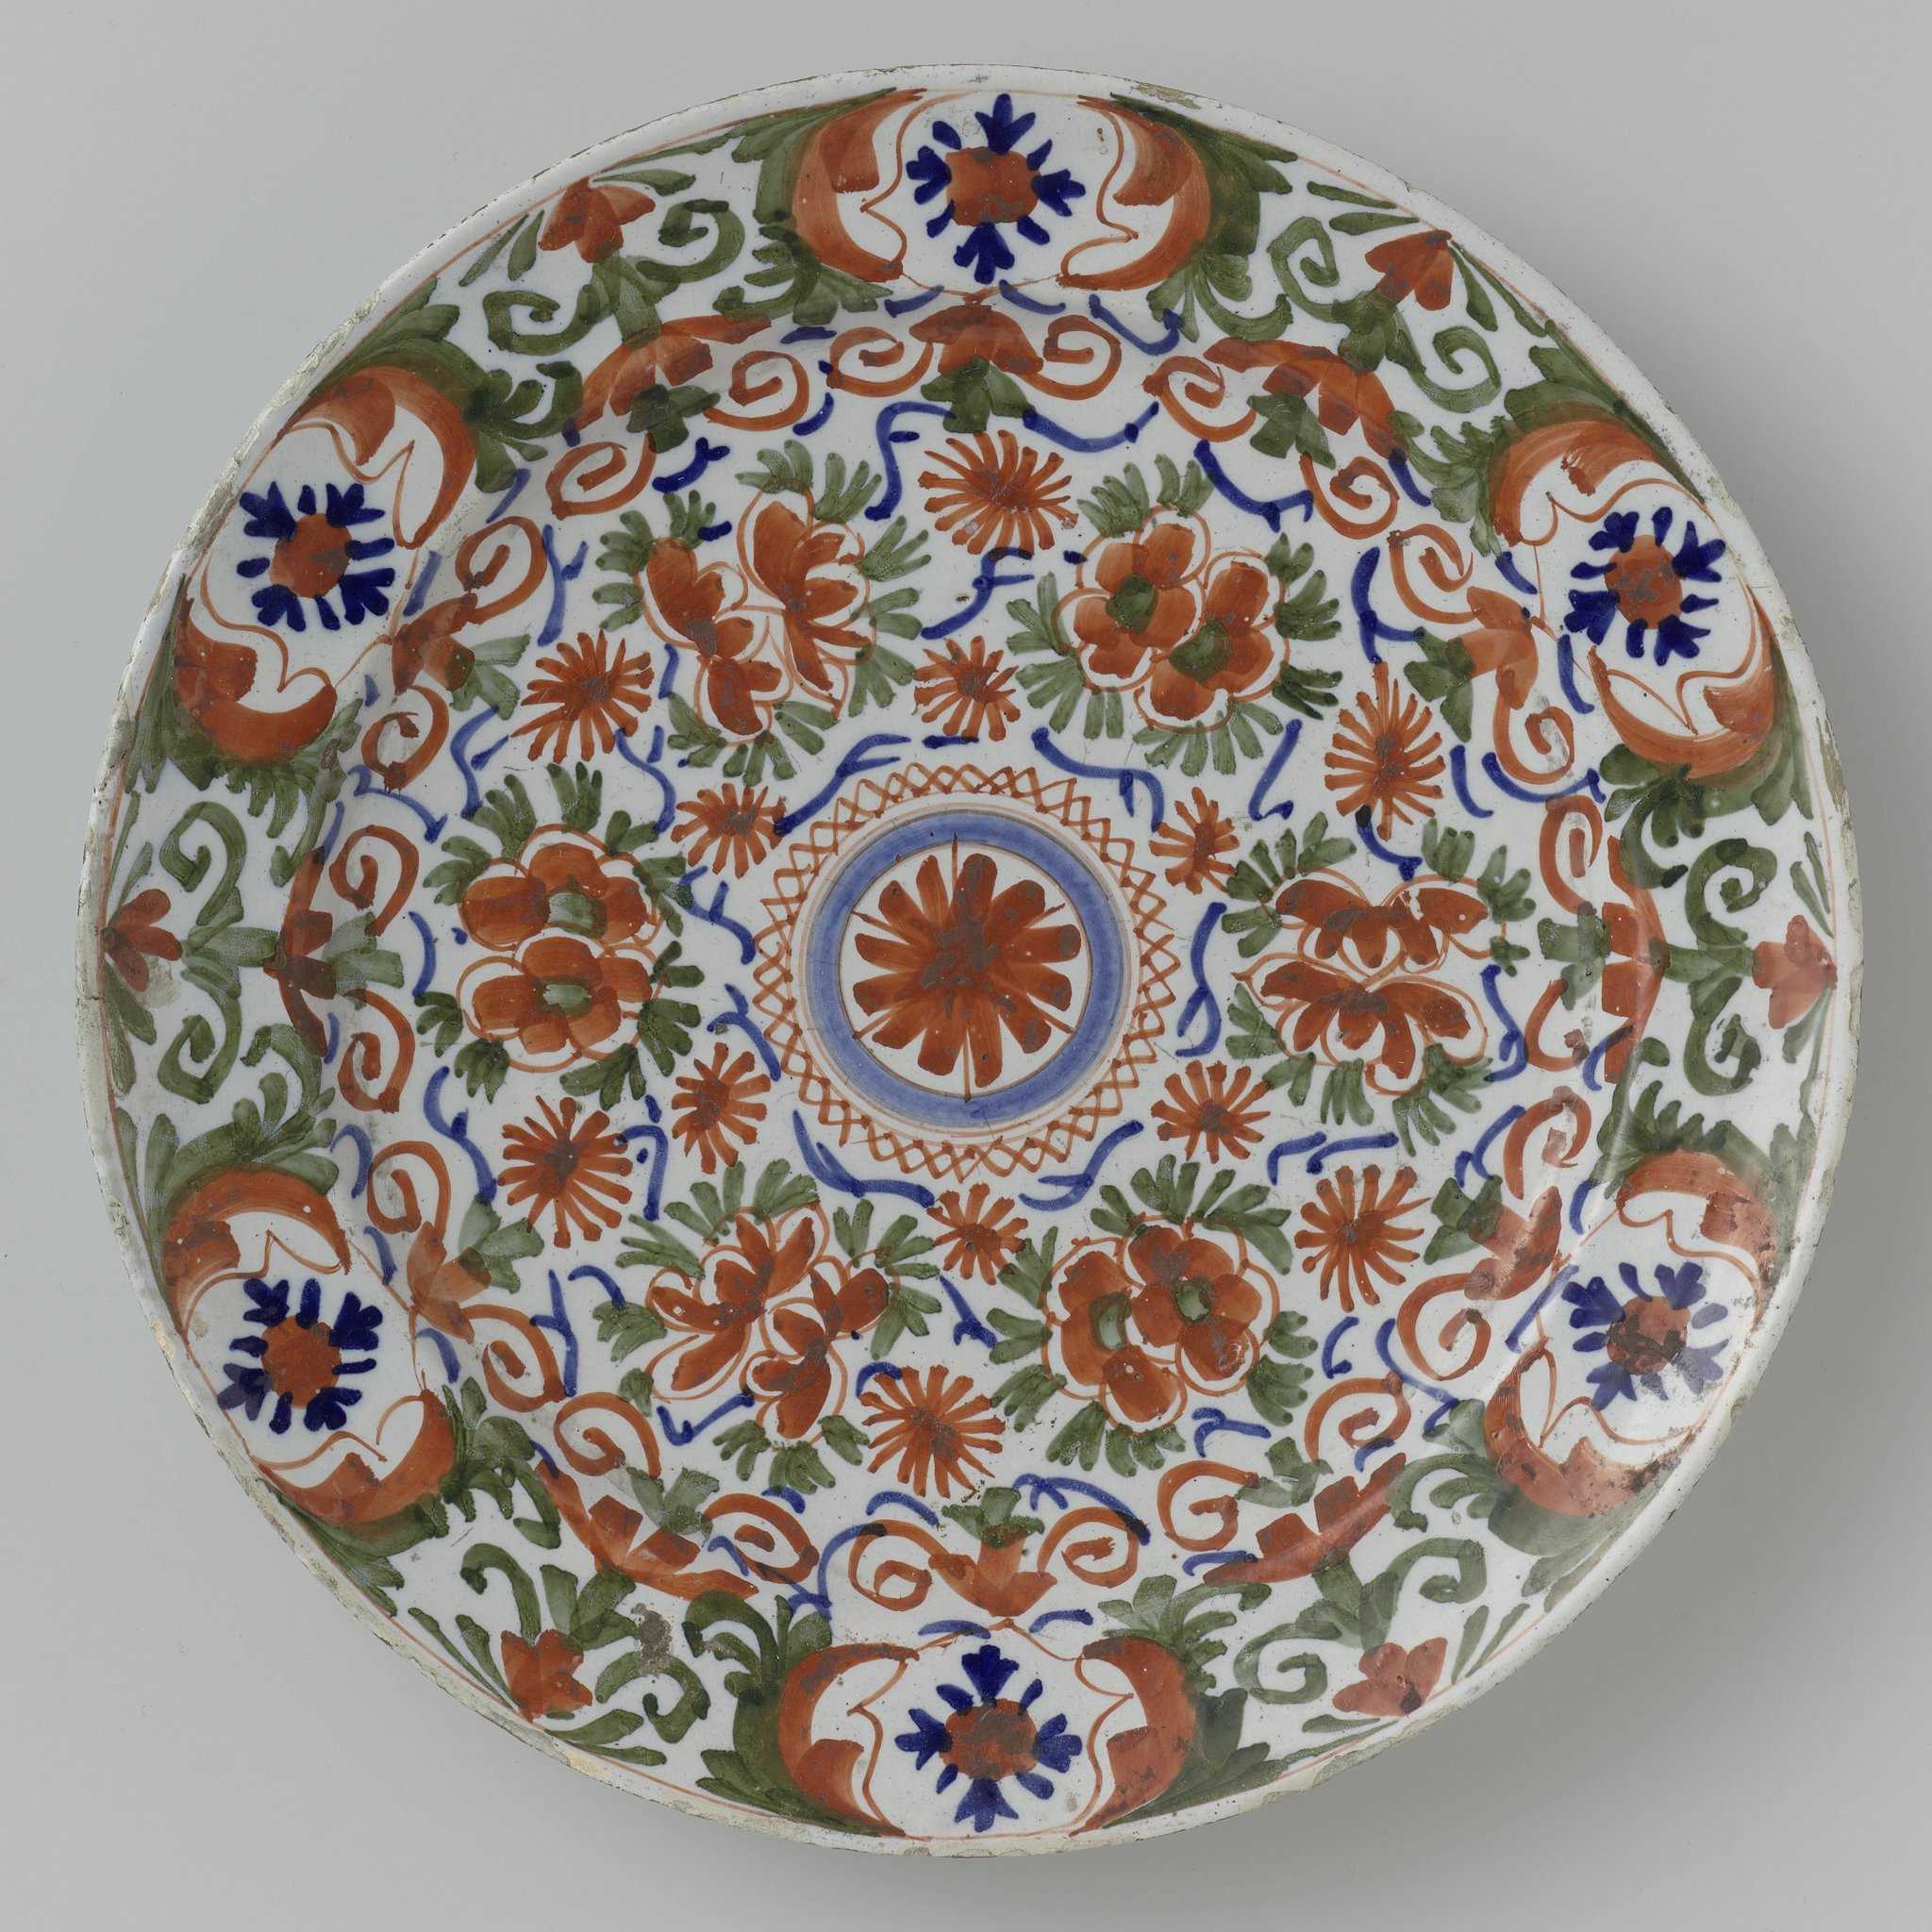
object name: plate dish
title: Bord van faience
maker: Anonymous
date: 1730-1770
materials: faience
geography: delft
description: Bord van faience. Veelkeurig beschilderd.